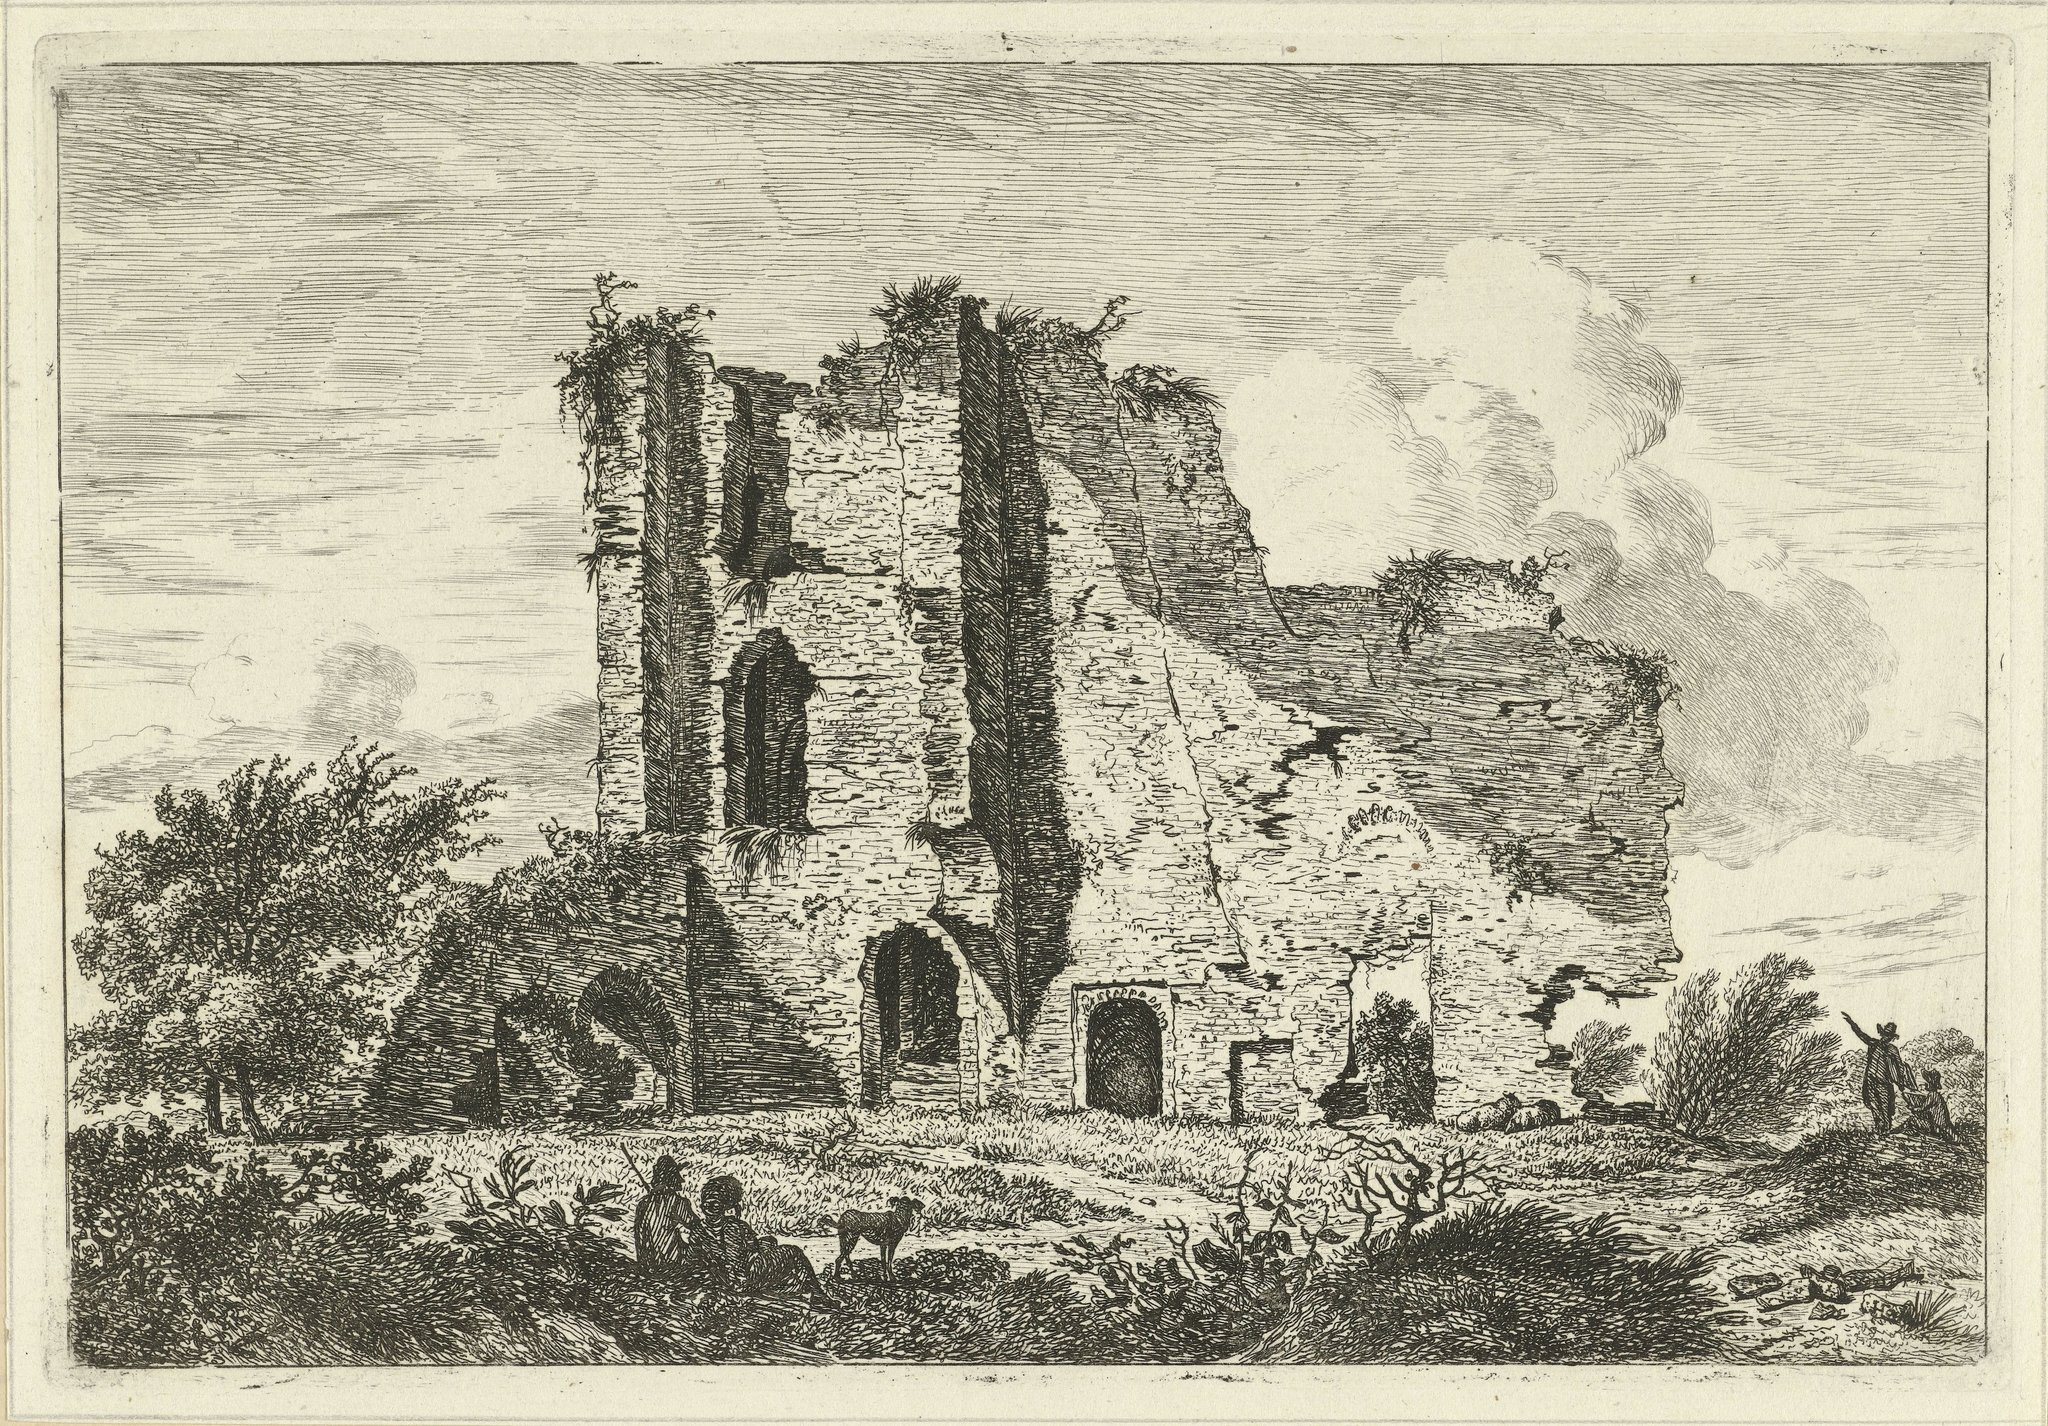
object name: print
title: Herders met hond bij ruïne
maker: hermanus fock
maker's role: conservator, draughtsman, painter, print maker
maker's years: 1766-1822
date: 1781-1822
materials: paper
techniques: etching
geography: amsterdam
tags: landscape with ruins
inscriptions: collector's mark: Lugt 924, collector's mark: Lugt 2228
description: Een gezicht op een ruïne. In de schaduw op de voorgrond zitten een man en een vrouw met een hond in het gras. Op de achtergrond, naast de ruïne, zit een persoon met een schetsboek op zijn schoot bij een wijzende man.